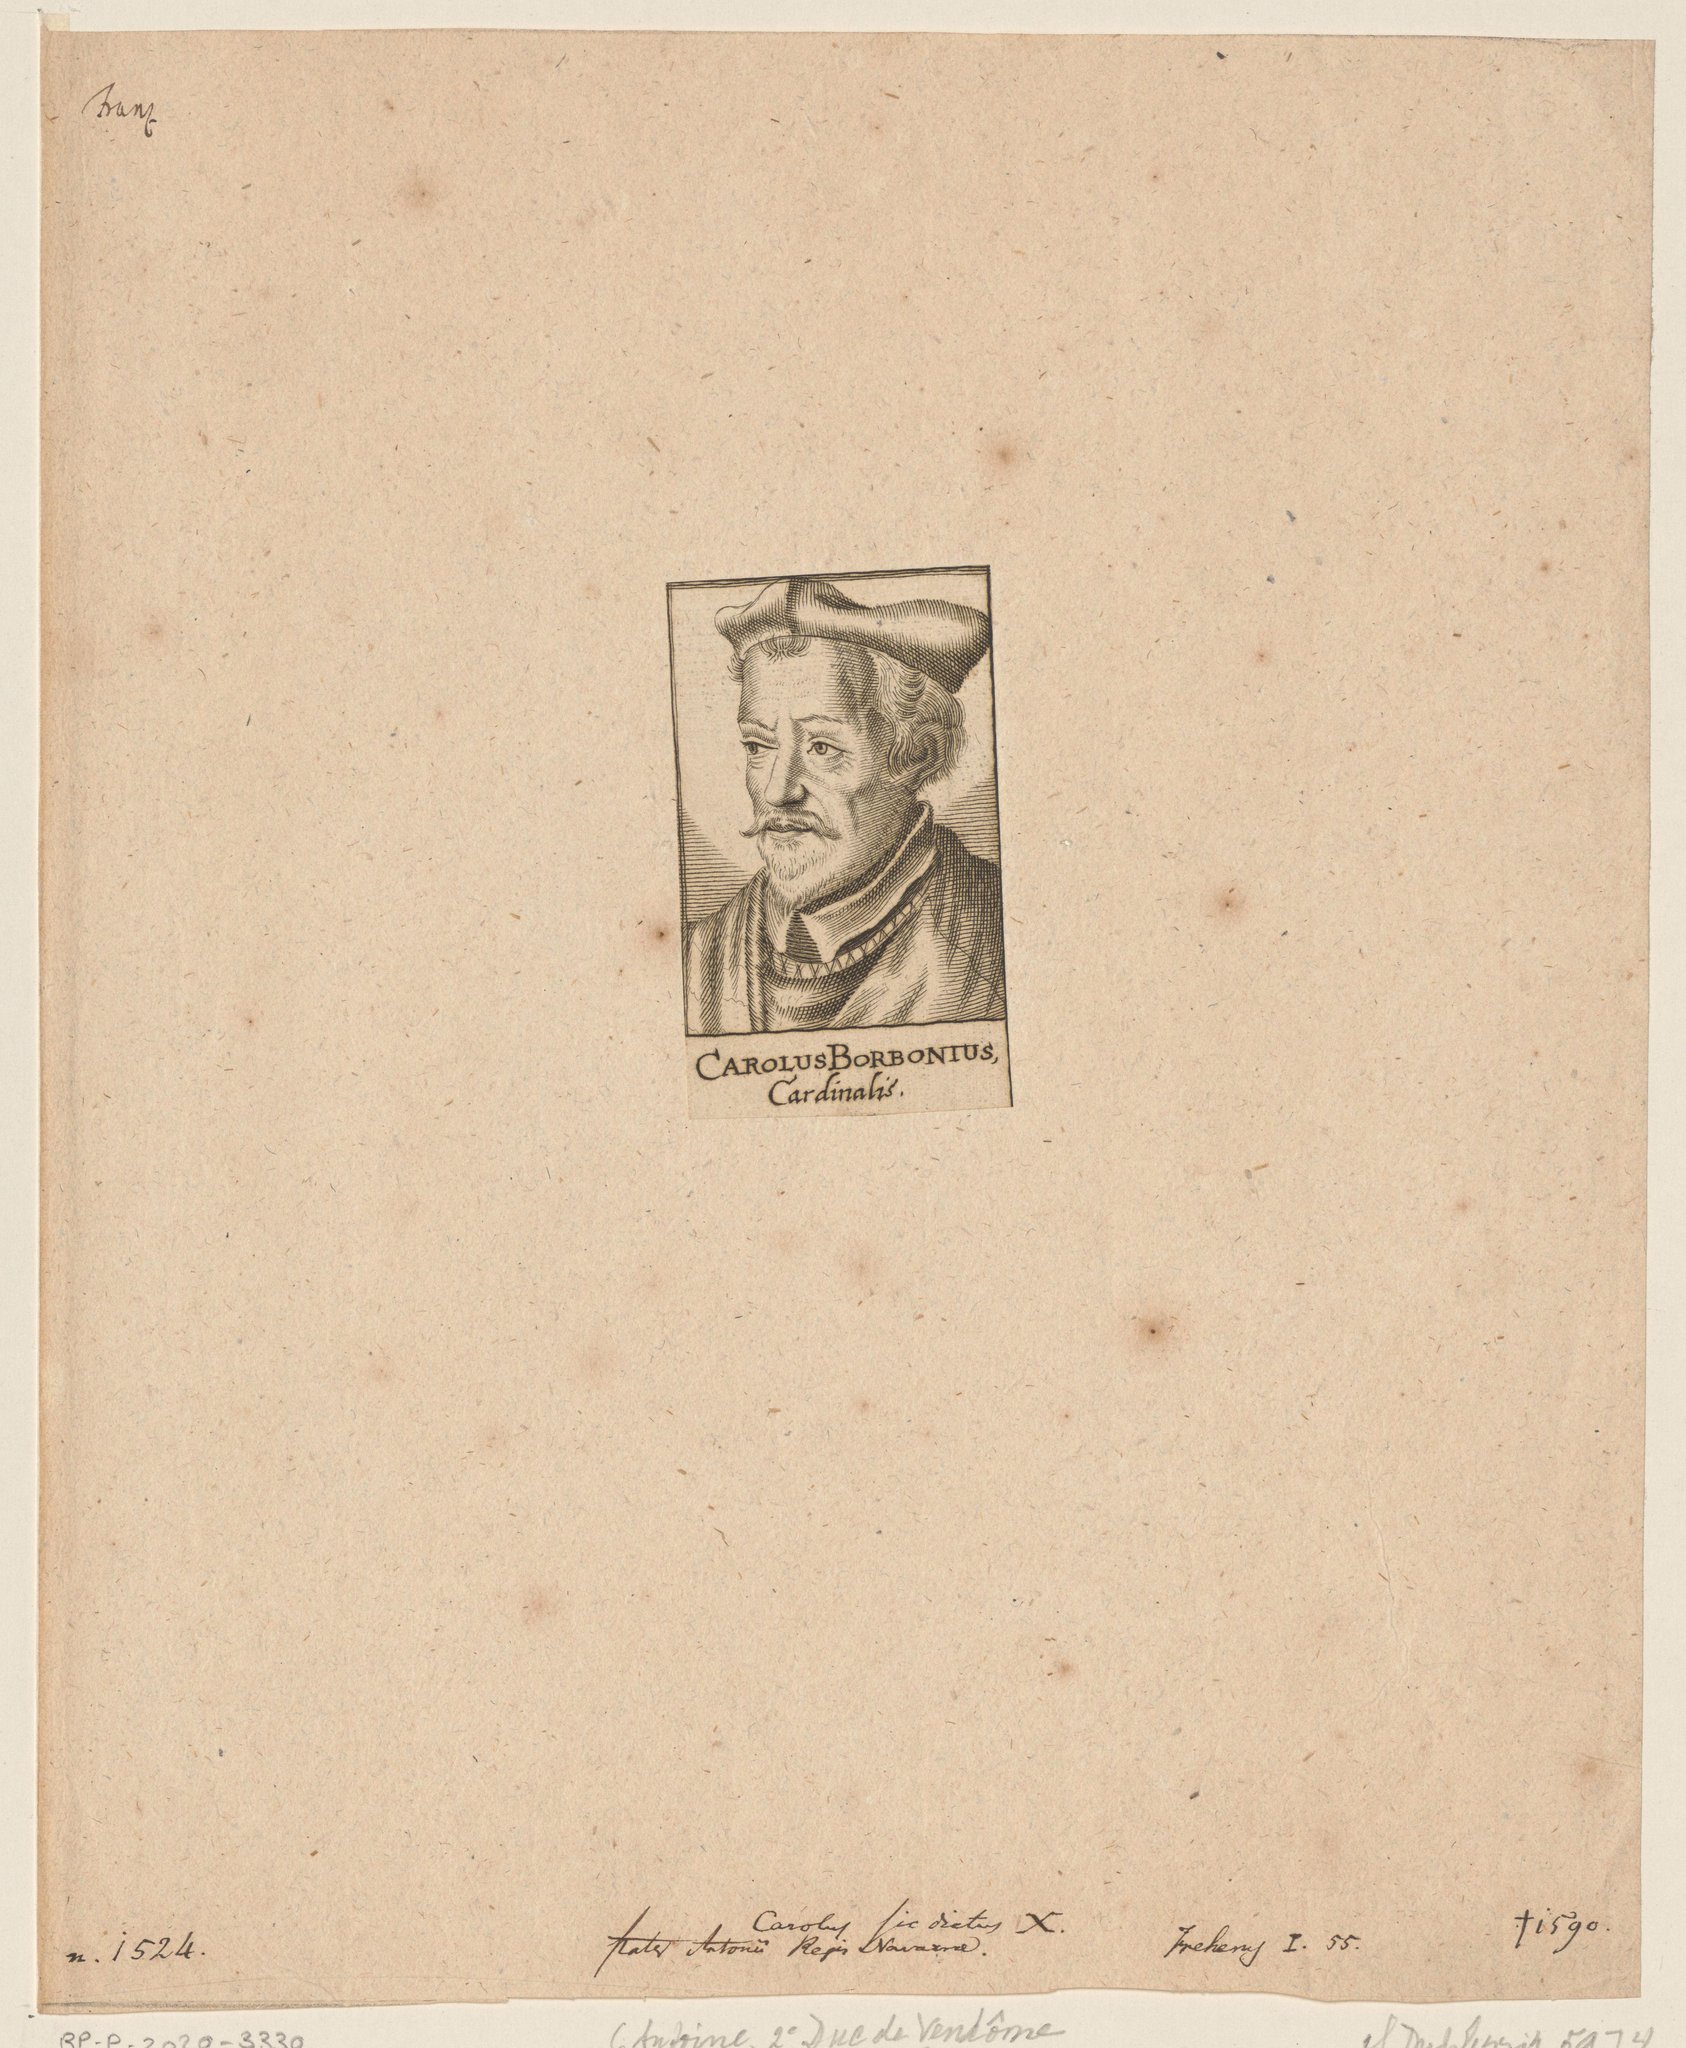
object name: print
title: Portret van Karel I van Bourbon-Vendôme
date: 1688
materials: paper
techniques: engraving, etching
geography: nuremberg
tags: charles ii de bourbon-vendôme, cardinal, historical persons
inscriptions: inscription: ‘n. 1524 pater Antonii (...)’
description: Prent uit: Freher, Paul. Theatrum virorum eruditione clarorum. Neurenberg: Johann Hoffmann, 1688.